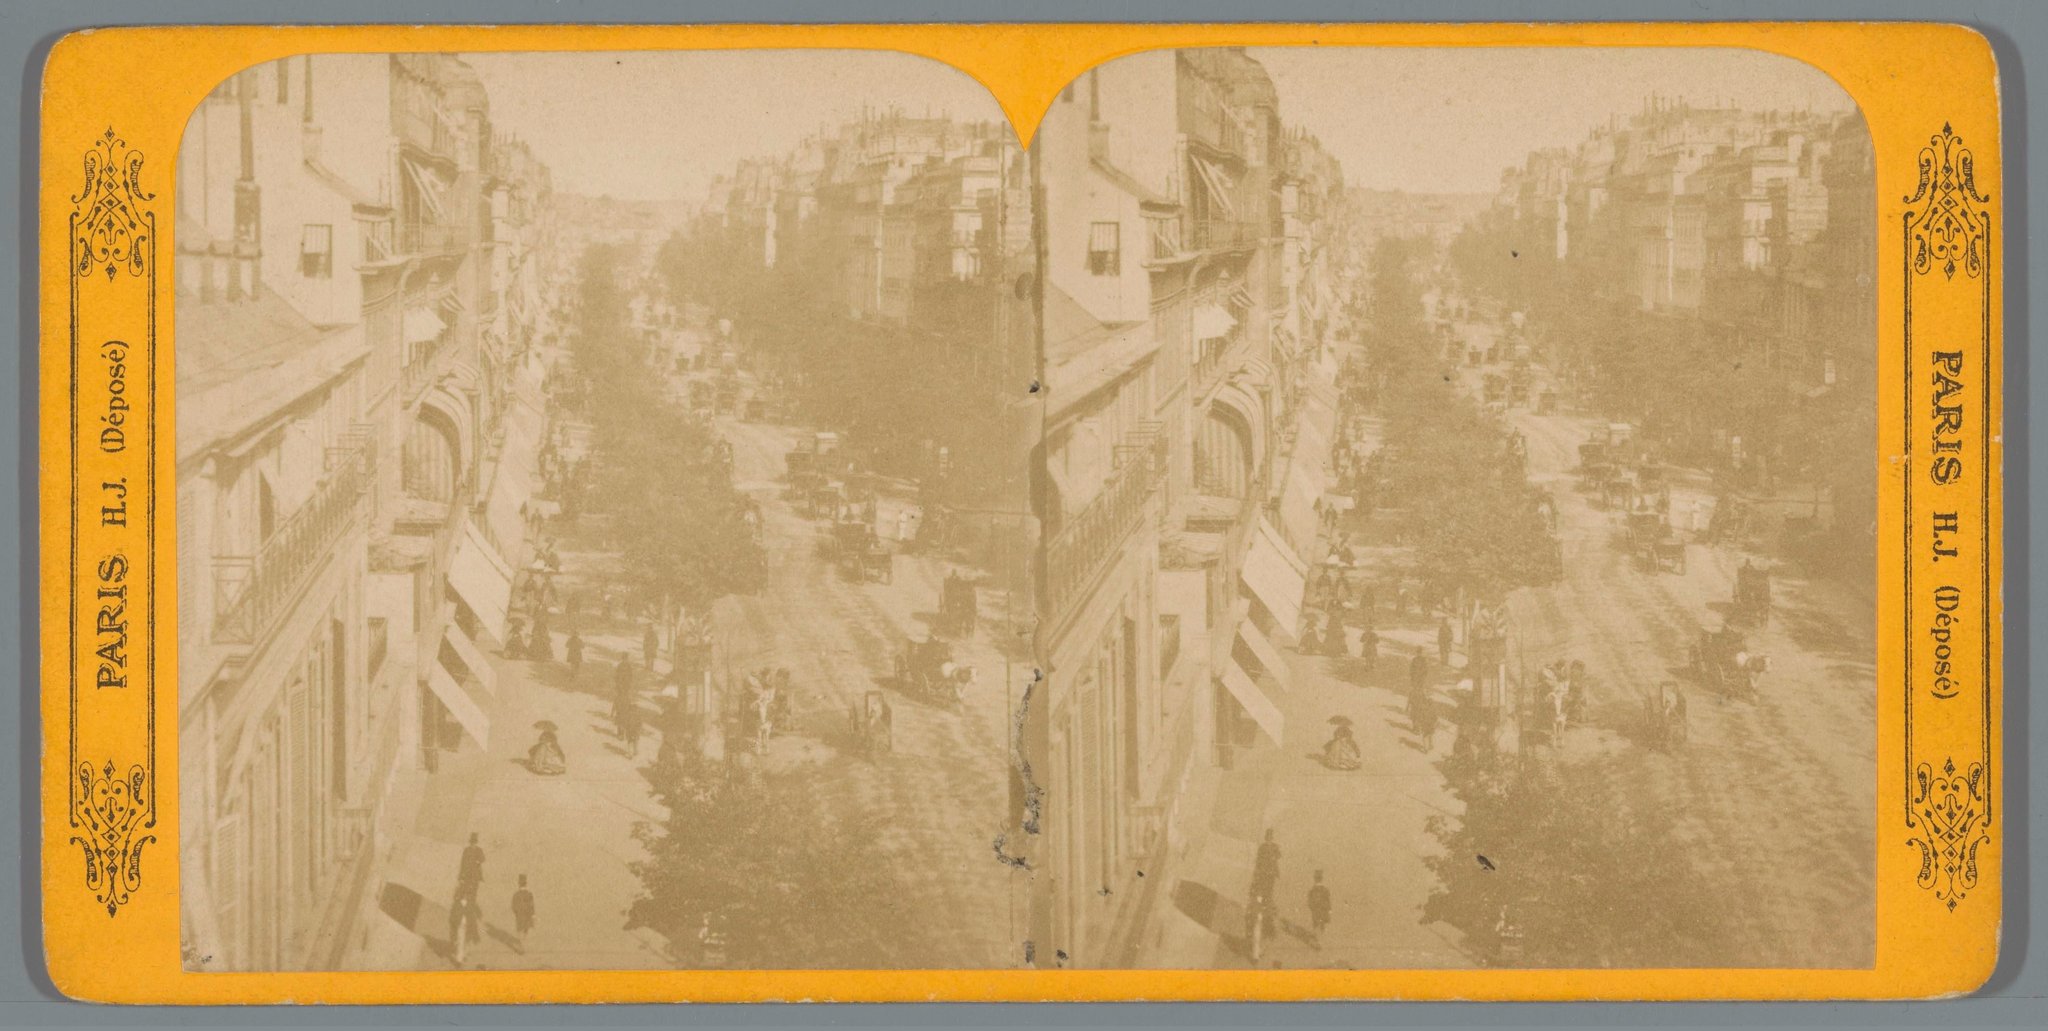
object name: stereograph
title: Boulevart Montmartre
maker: hippolyte jouvin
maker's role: fotograaf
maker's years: 1825-1889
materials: cardboard, photographic support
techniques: albumen print, photography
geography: paris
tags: animal traction, animal-drawn vehicle (carriage etc.), street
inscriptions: number: ‘No. 191’